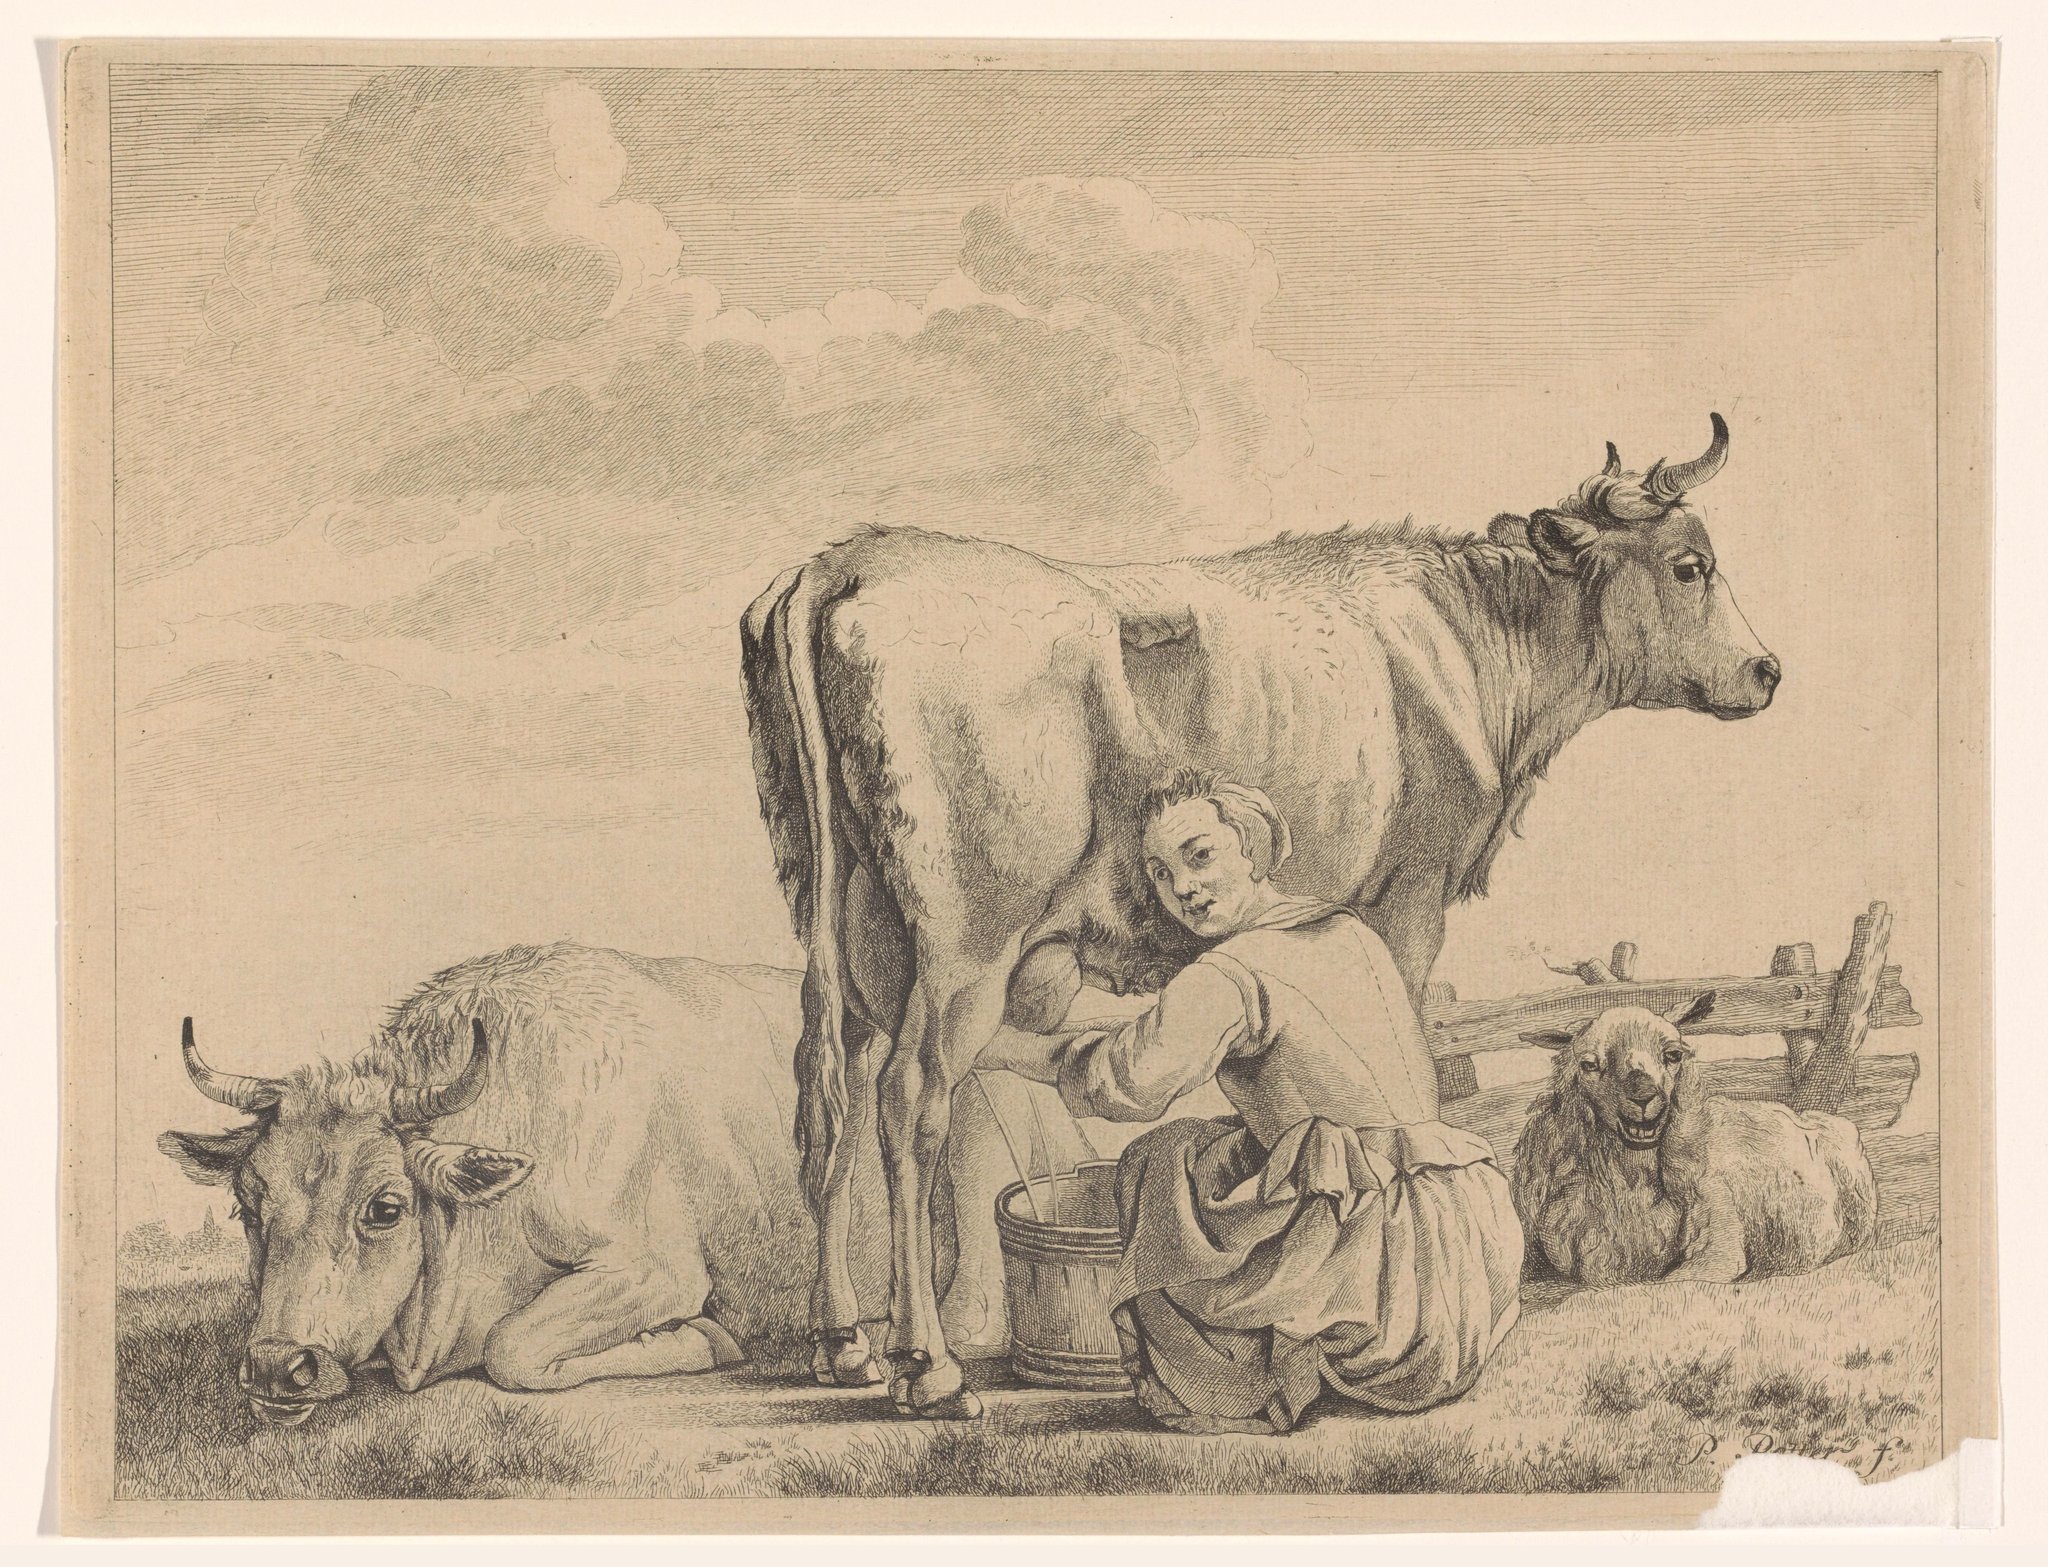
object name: print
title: Melkmeid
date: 1768-1796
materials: paper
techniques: etching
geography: leiden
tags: cow, milkmaid, milking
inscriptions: collector's mark: Lugt 240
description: Een zittende melkende vrouw bij twee koeien en een schaap.